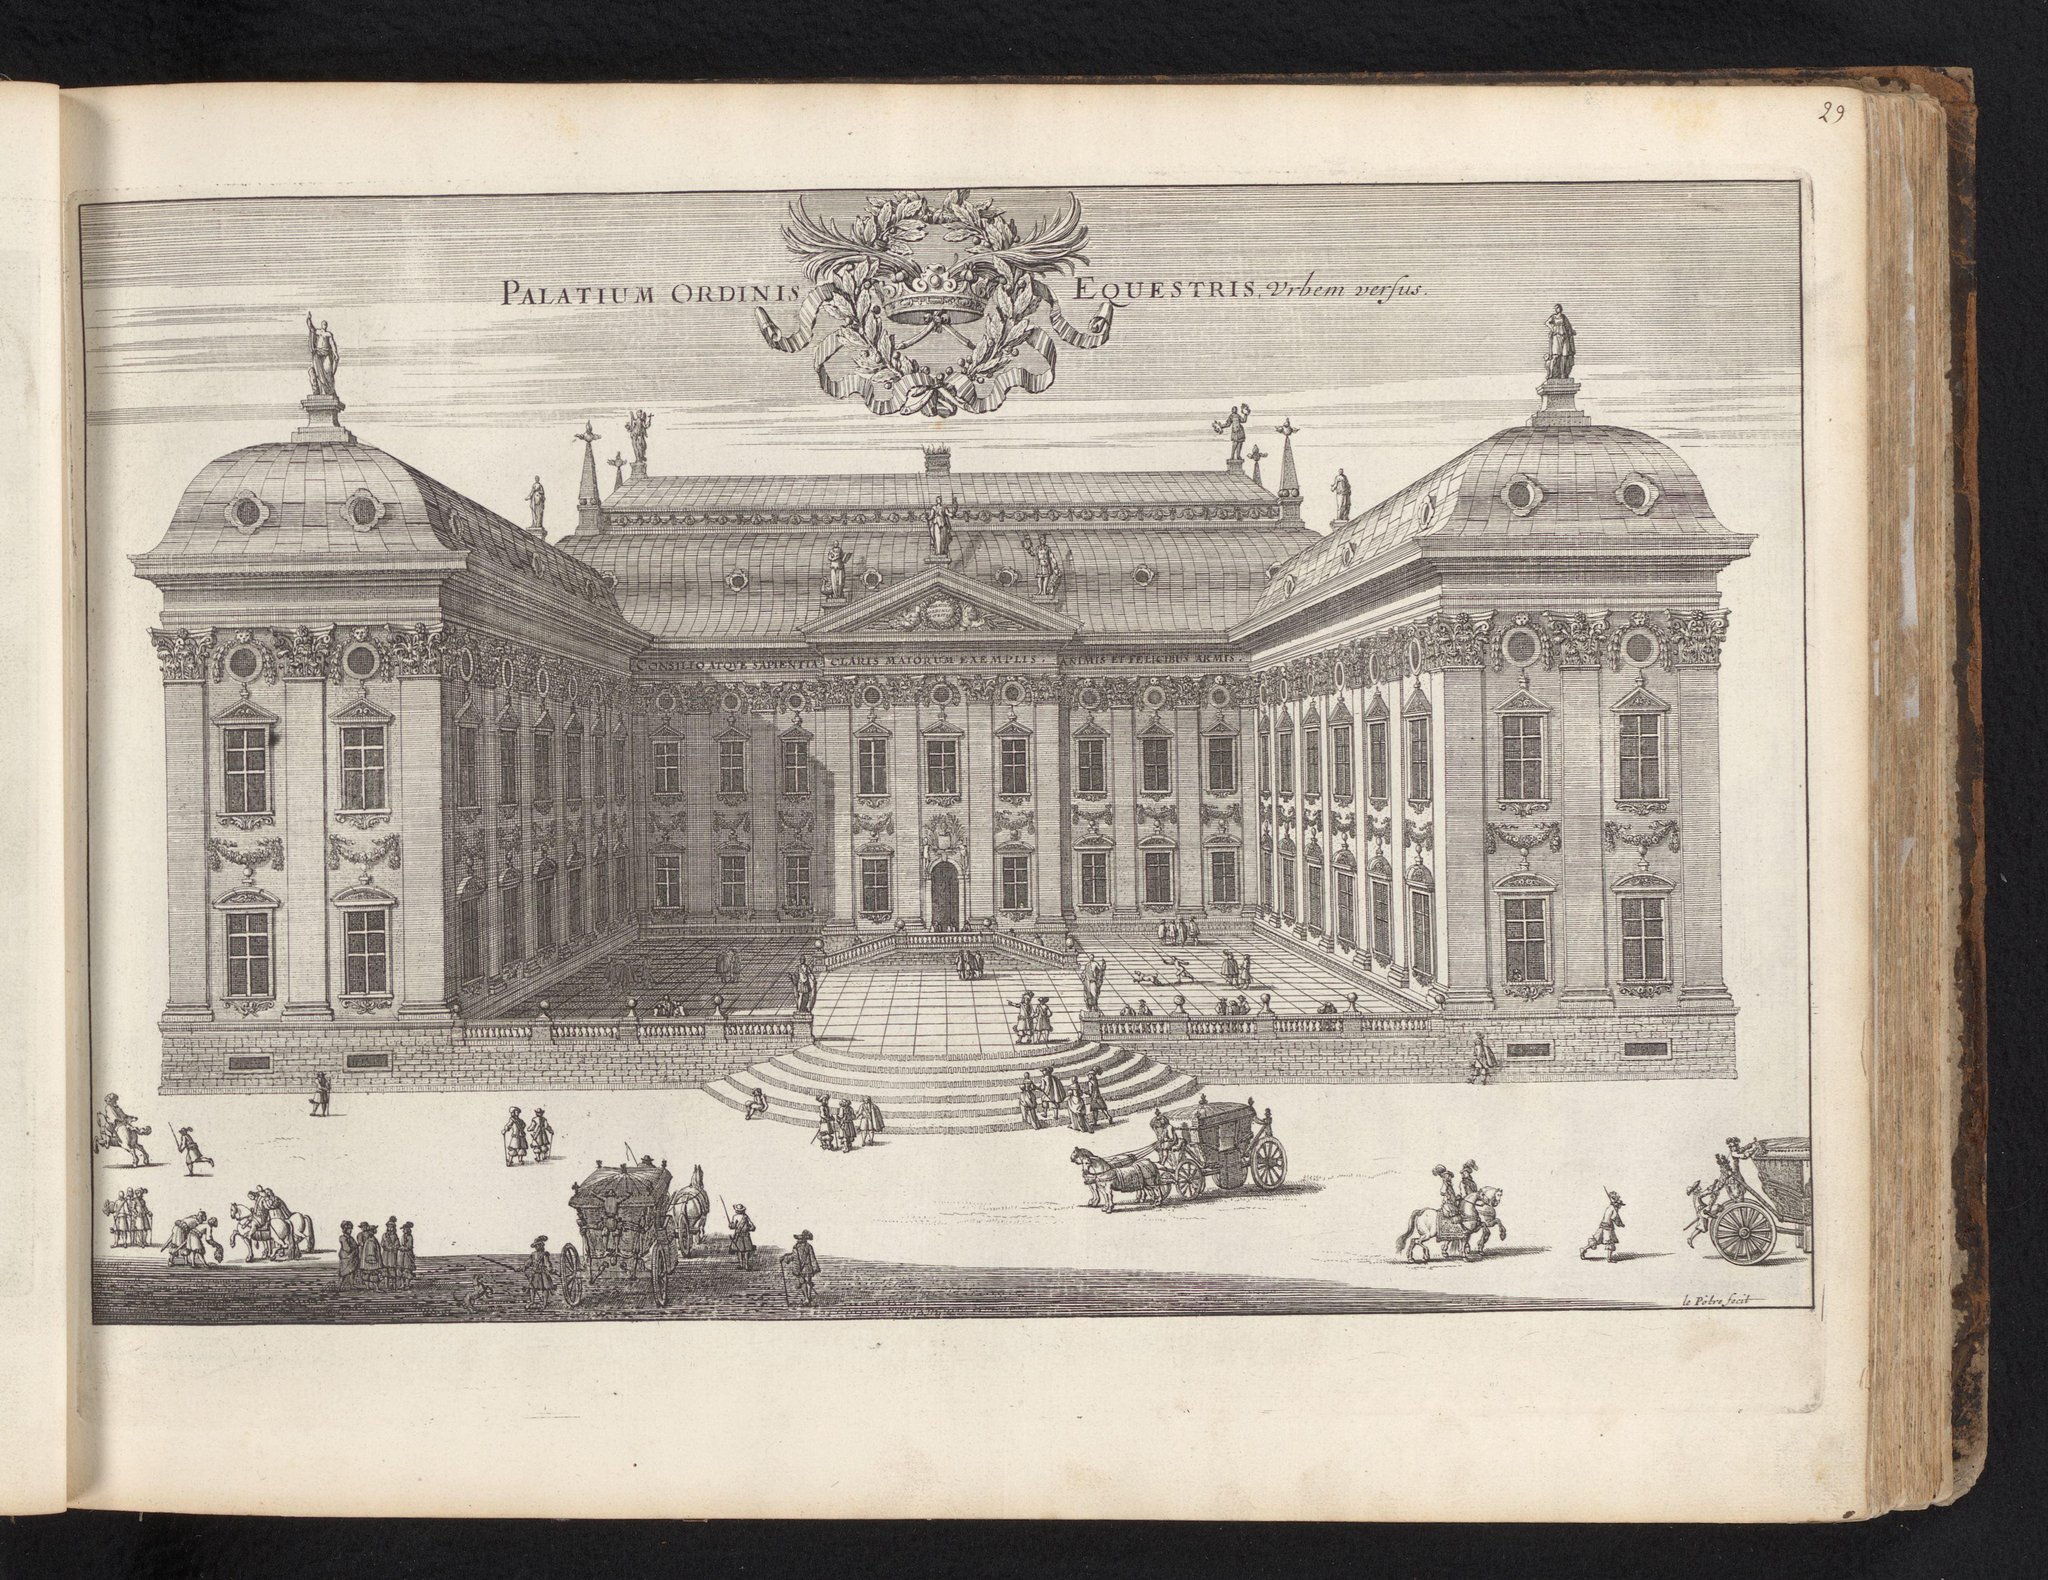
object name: album leaf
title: Palatium Ordinis Equestris urbem versus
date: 1670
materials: paper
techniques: etching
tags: civic architecture; edifices; dwellings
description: Het Riddarhuset (Ridderhuis), de vaste vergaderplaats van de Zweedse adel in Stockholm. Op de voorgrond verschillende rijtuigen. De prent maakt deel uit van een album.